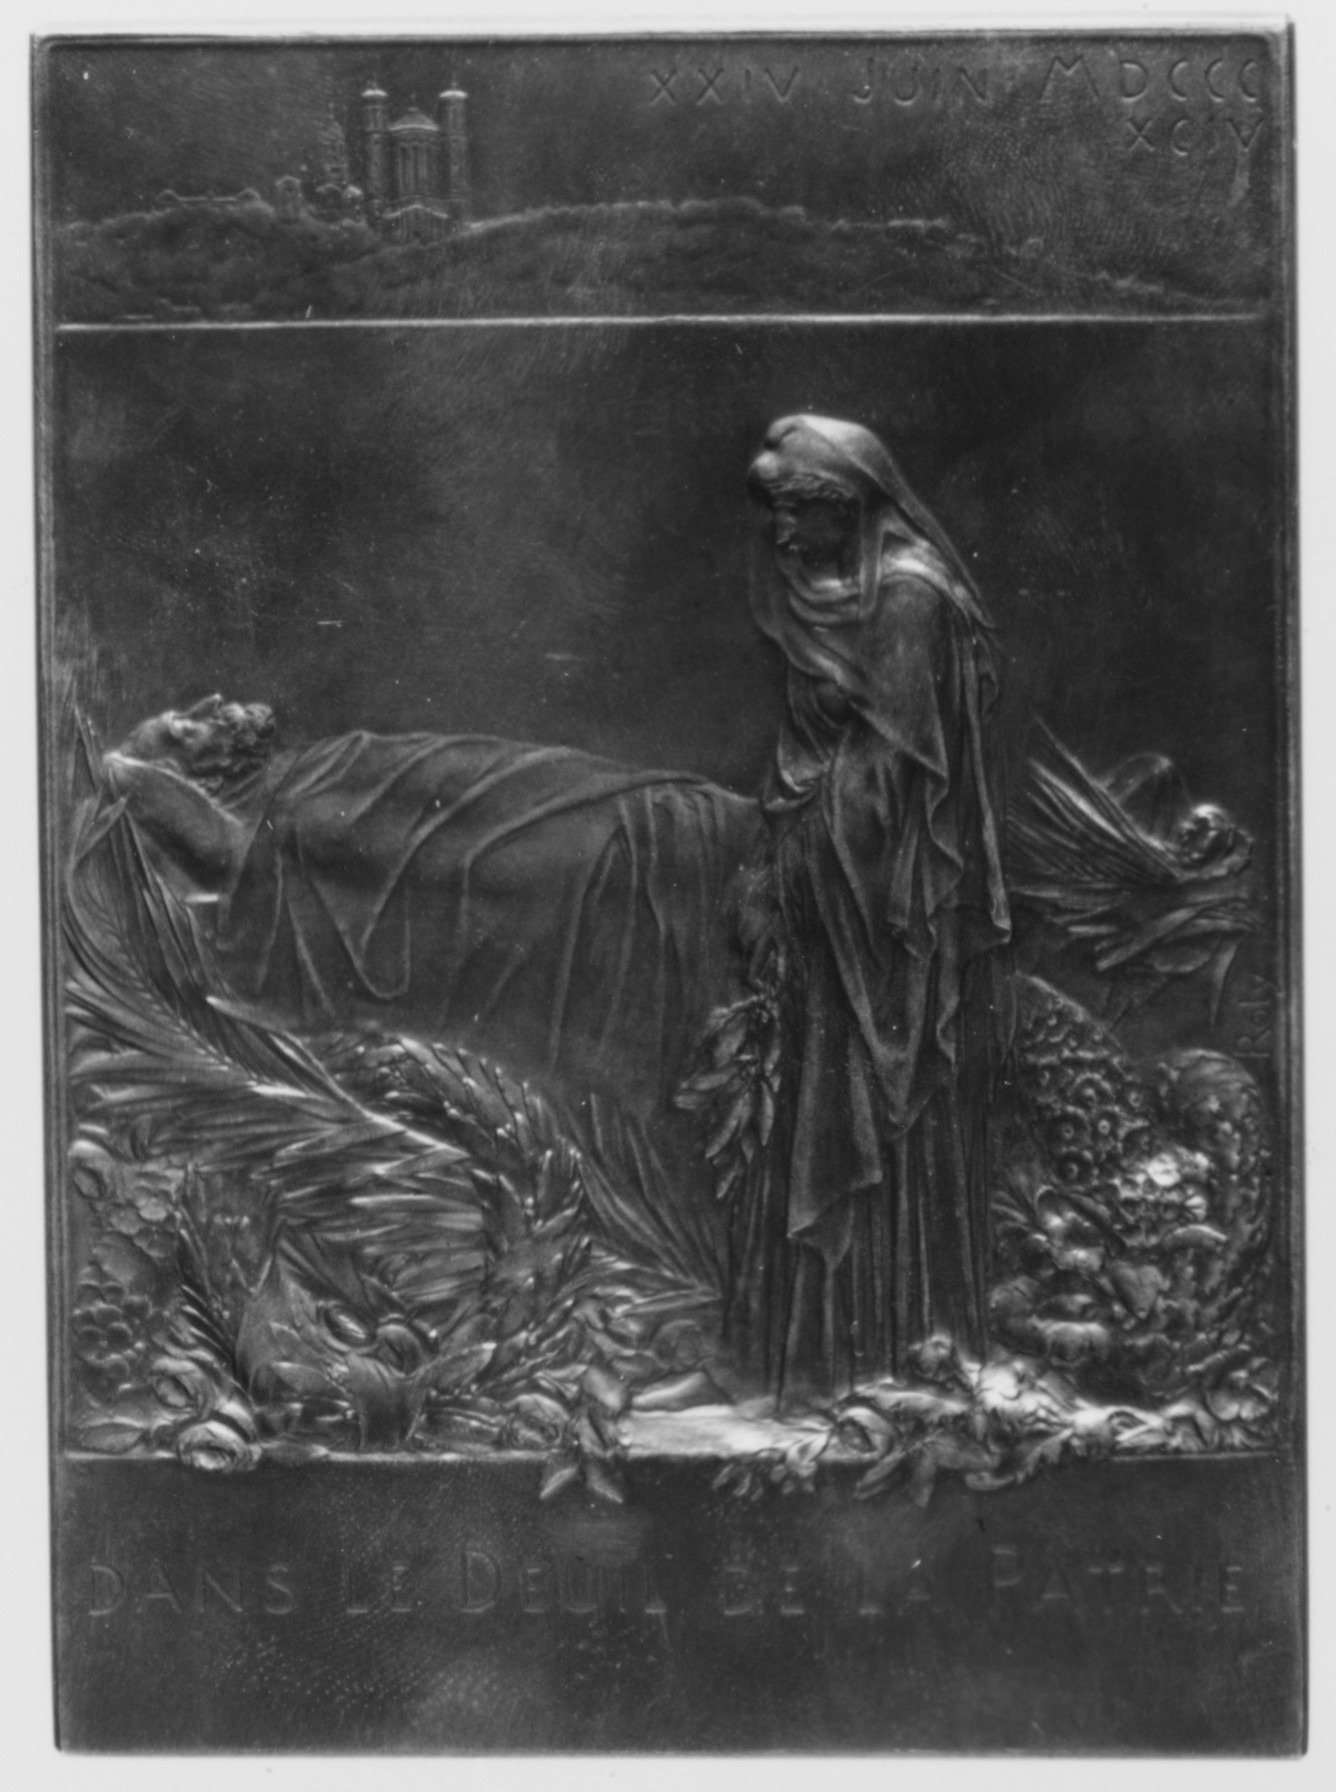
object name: medal box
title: The Death of Sadi Carnot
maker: louis-oscar roty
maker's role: artist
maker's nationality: french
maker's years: 1846-1911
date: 1894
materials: bronze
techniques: struck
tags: men,women,death